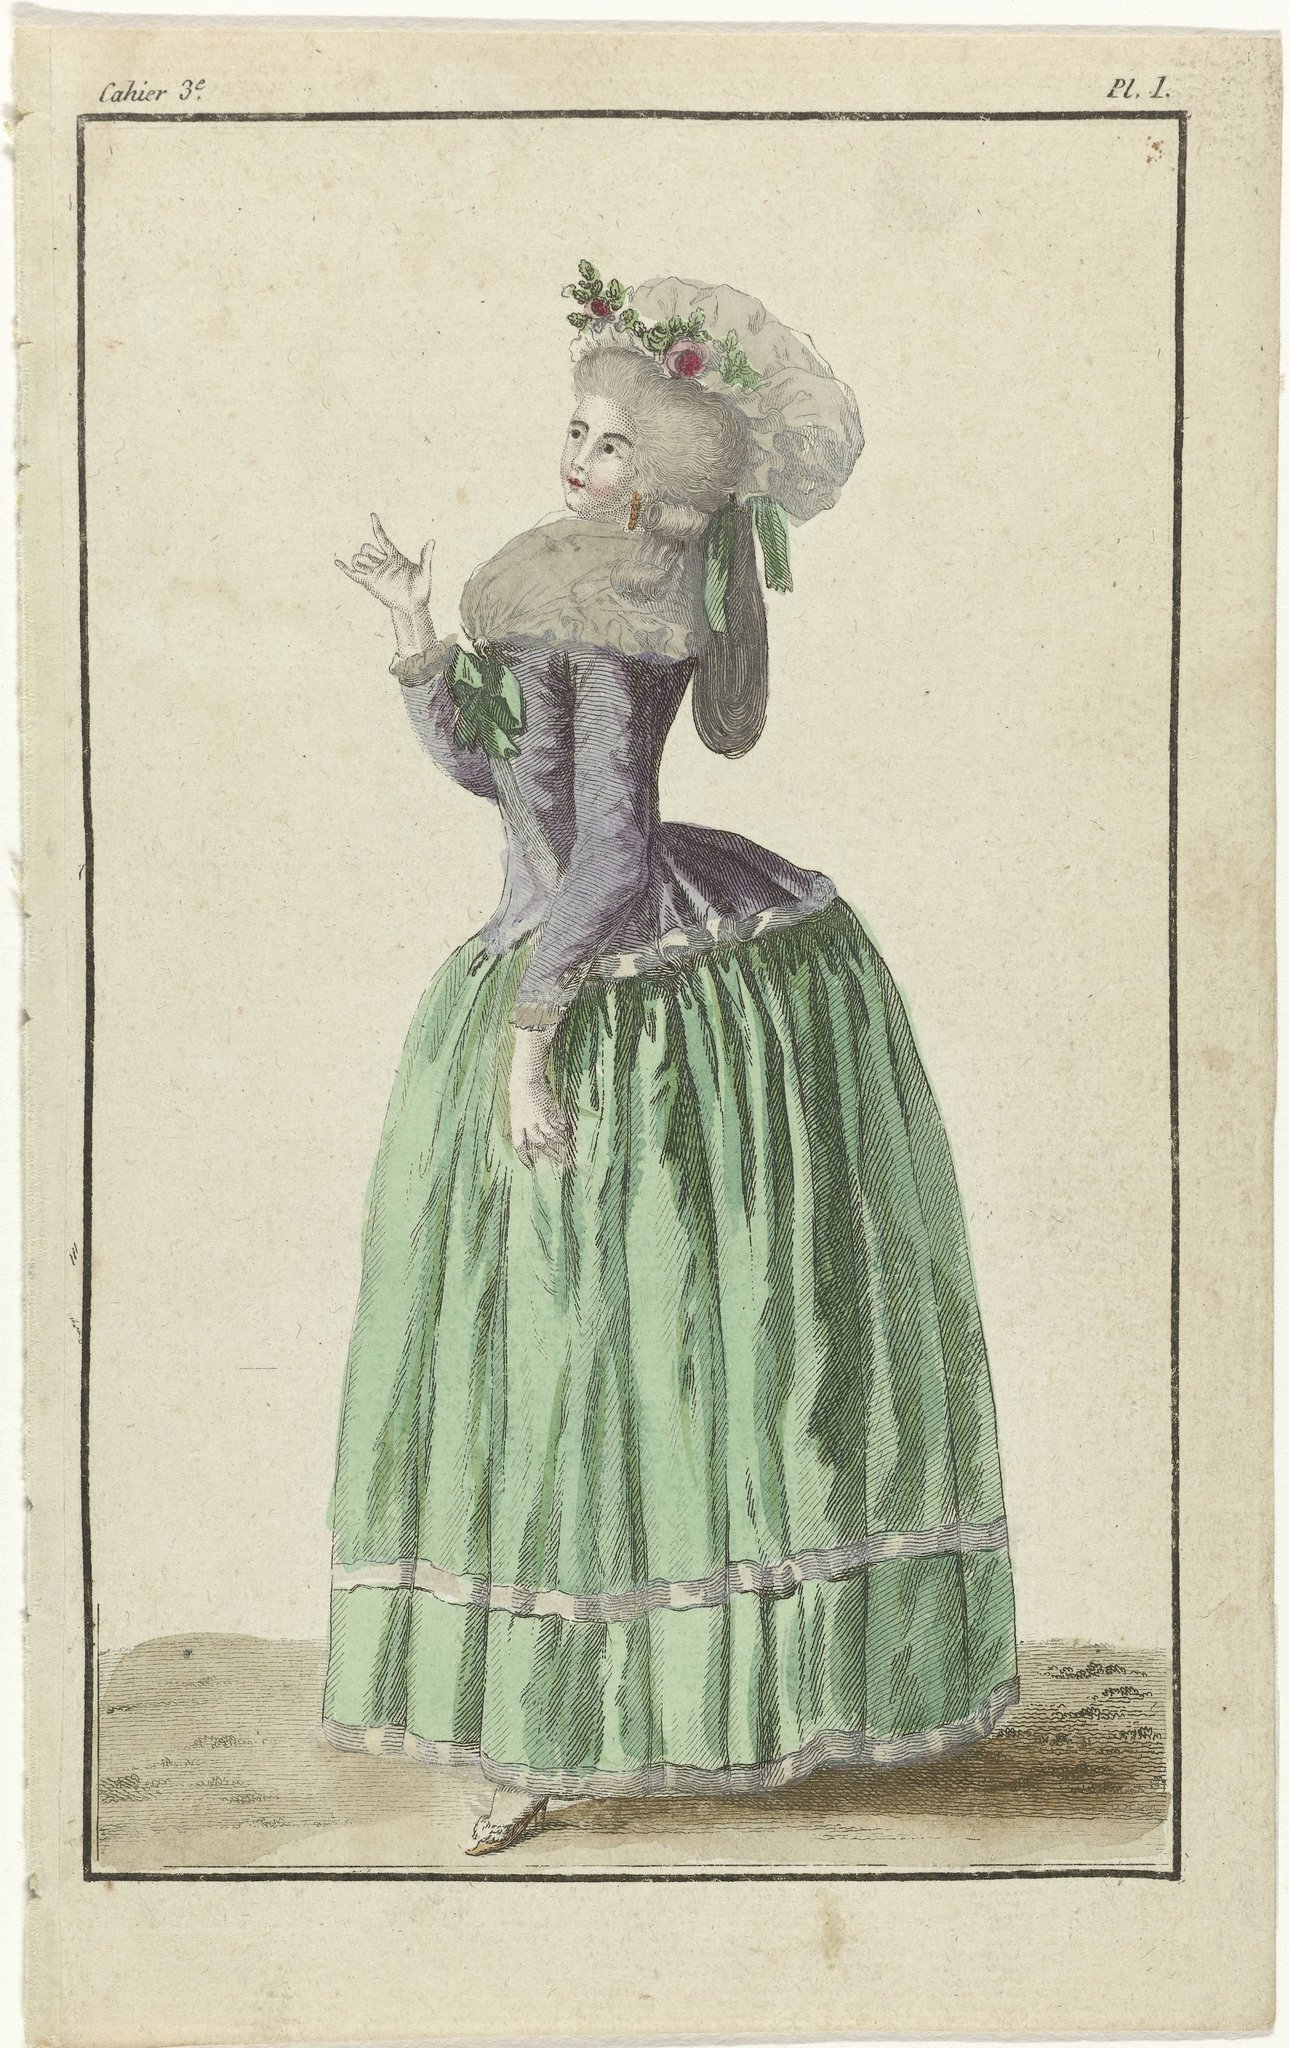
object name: fashion print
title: Cabinet des Modes ou les Modes Nouvelles, 3e Cahier, 15 décembre 1785, pl. I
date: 1785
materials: paper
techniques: engraving, hand coloring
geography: paris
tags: corsage (+ women's clothes), clothing for the upper part of the body (caraco) (+ women's clothes), ear-rings (+ women's clothes), head-gear: cap (+ women's clothes), fashion plates, shoes, sandals (+ women's clothes), skirt (+ women's clothes), piece of clothing covering the breast or décolleté (fichu) (+ women's clothes)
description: Volgens de begeleidende tekst is de vrouw gekleed in een 'Pierrot'. Op het hoofd een 'Bonnet en Pouf' versierd met een guirlande van rozen en een breed groen lint. 'Coëffure ordinaire' met twee krullen en een chignon. Fichu van 'gaze d'Italie'. Paars jakje (caraco genaamd), afgezet met wit, met een strik van groen lint middenvoor. Appelgroene (onder)rok versierd met twee witte linten. Chinese schoentjes in de kleur 'carmelite', versierd met wit lint, 'à la Jeanette'. De prent maakt deel uit van het 3e Cahier uit Cabinet des Modes ou les Modes Nouvelles. De serie bestaat uit 72 modeprenten, uitgegeven door Buisson, Parijs, 15 november 1785 - 1 november 1786.